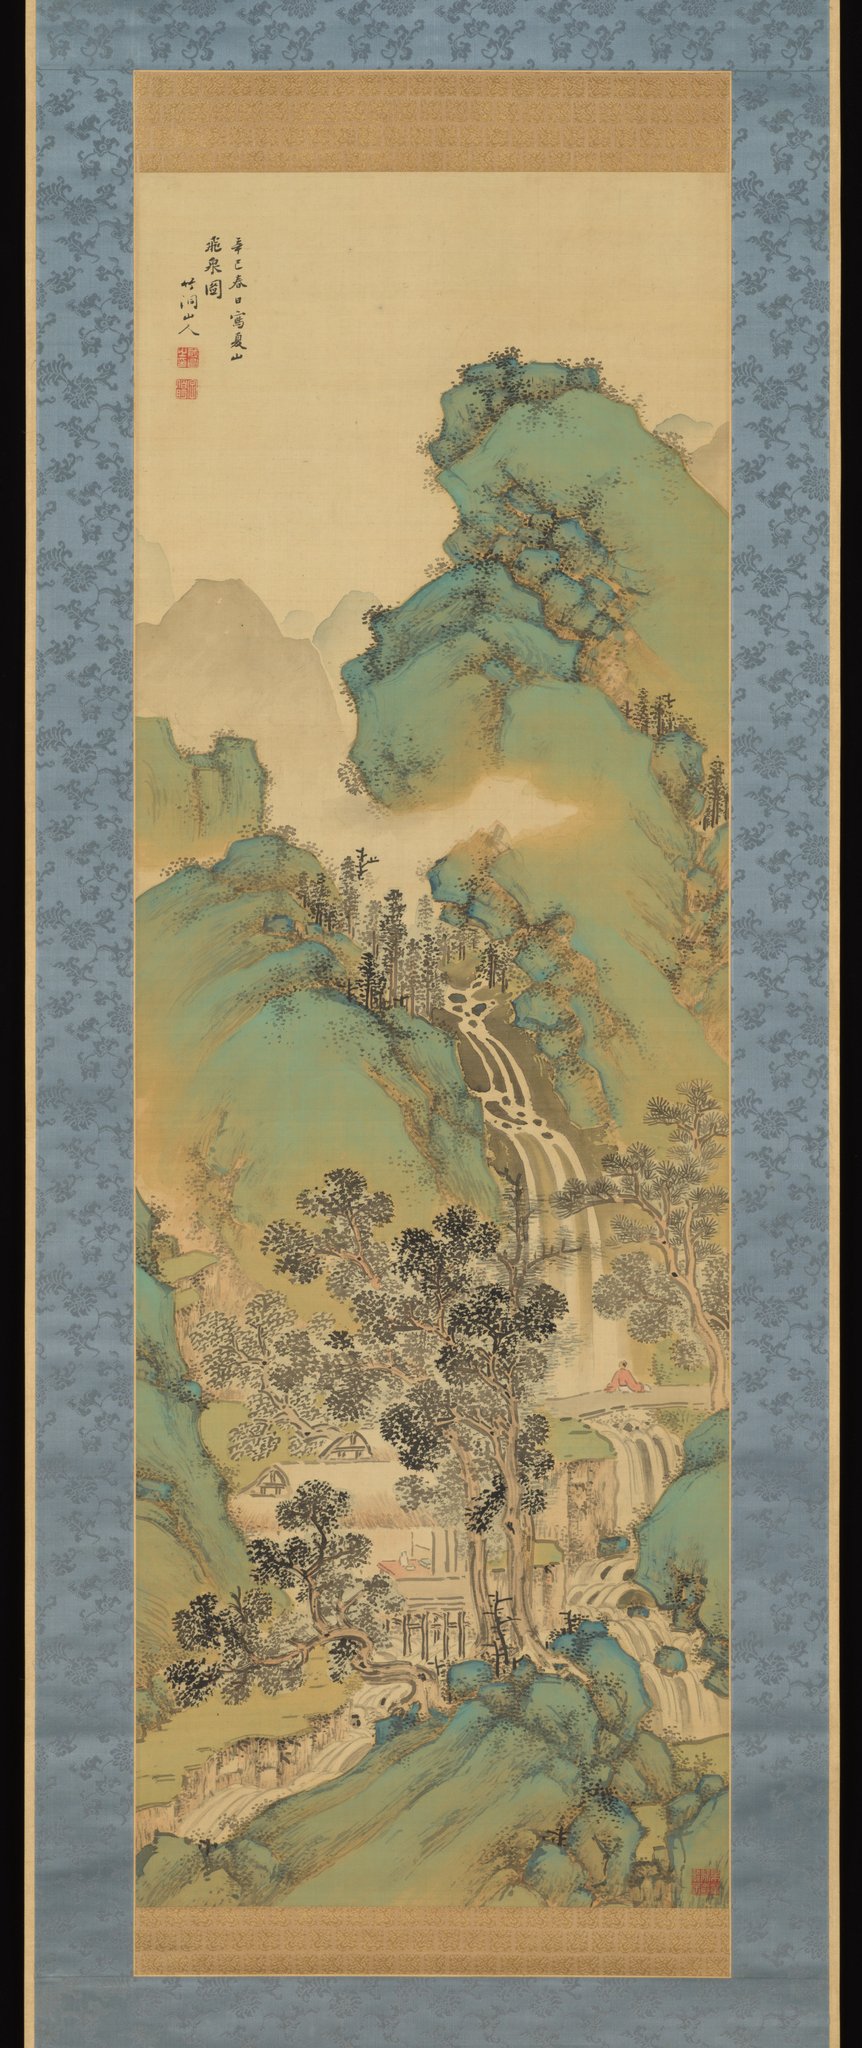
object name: hanging scroll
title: Waterfall in Summer Mountains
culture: japanese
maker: nakabayashi chikutō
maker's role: artist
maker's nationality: japanese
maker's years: 1776-1853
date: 1821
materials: ink, silk